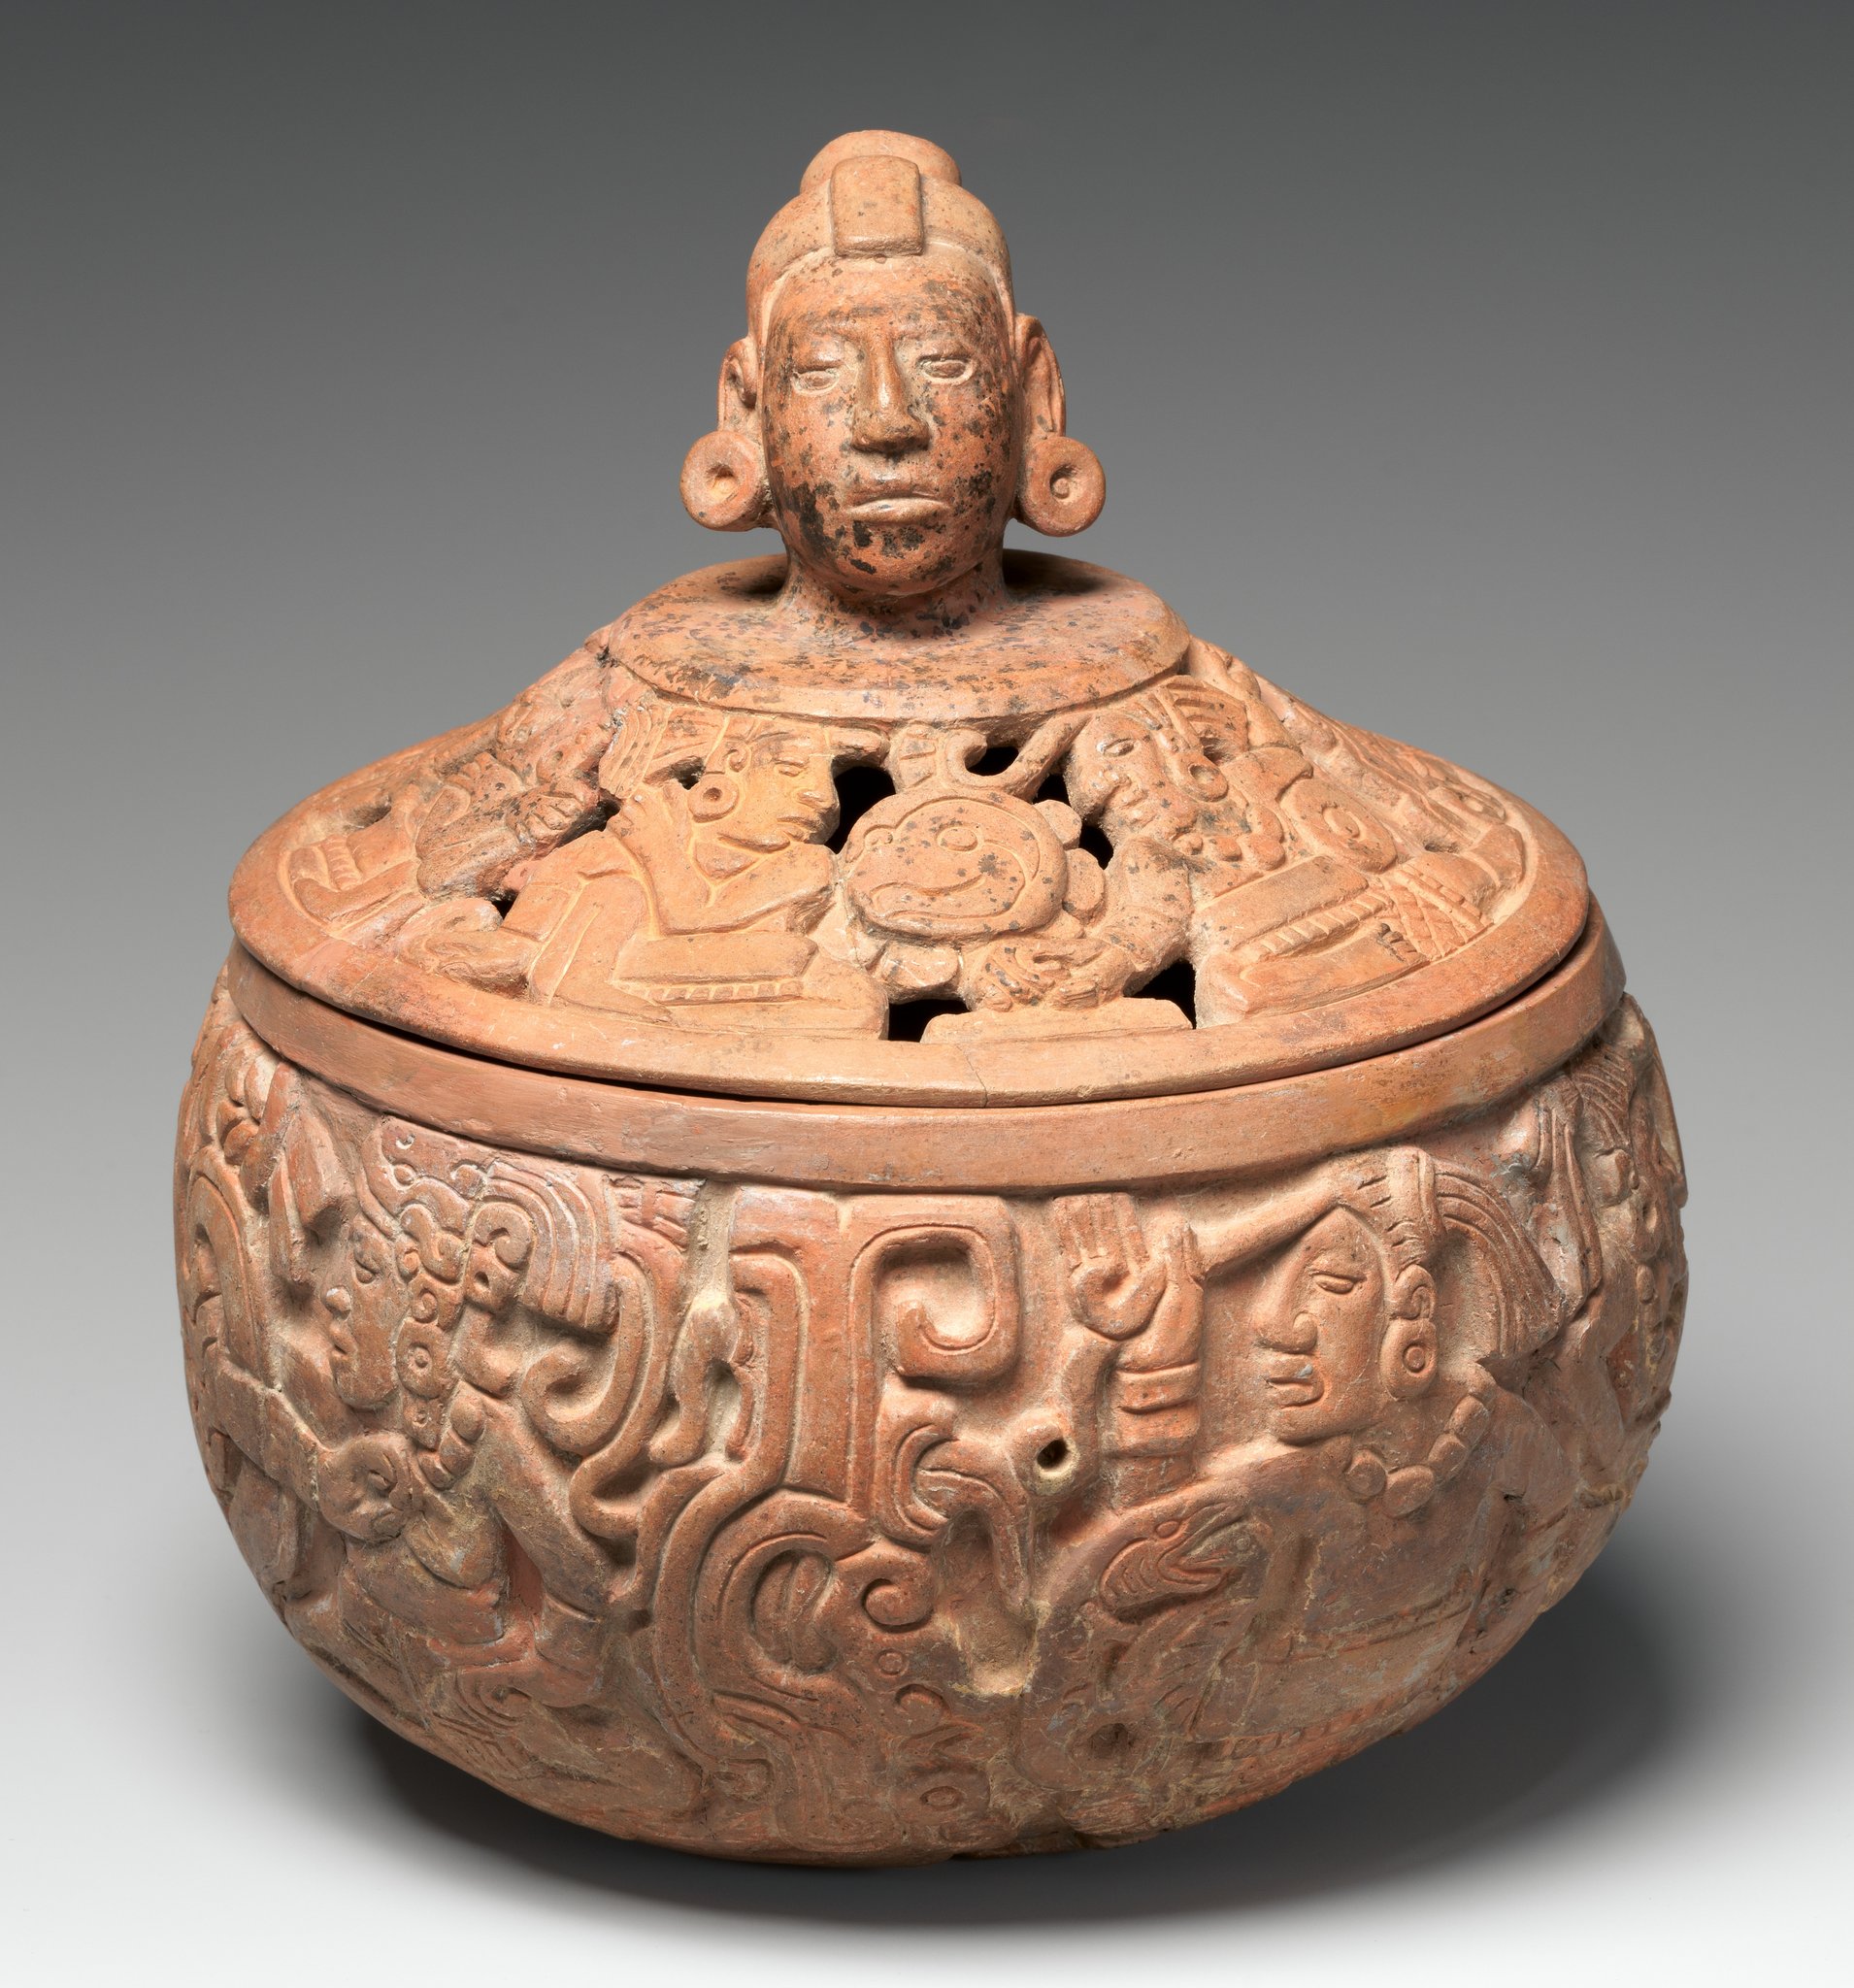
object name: bowl with lid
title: Lidded bowl with ballgame scenes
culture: central veracruz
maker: río blanco artist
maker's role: artist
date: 500-900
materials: ceramic, paint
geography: mexico